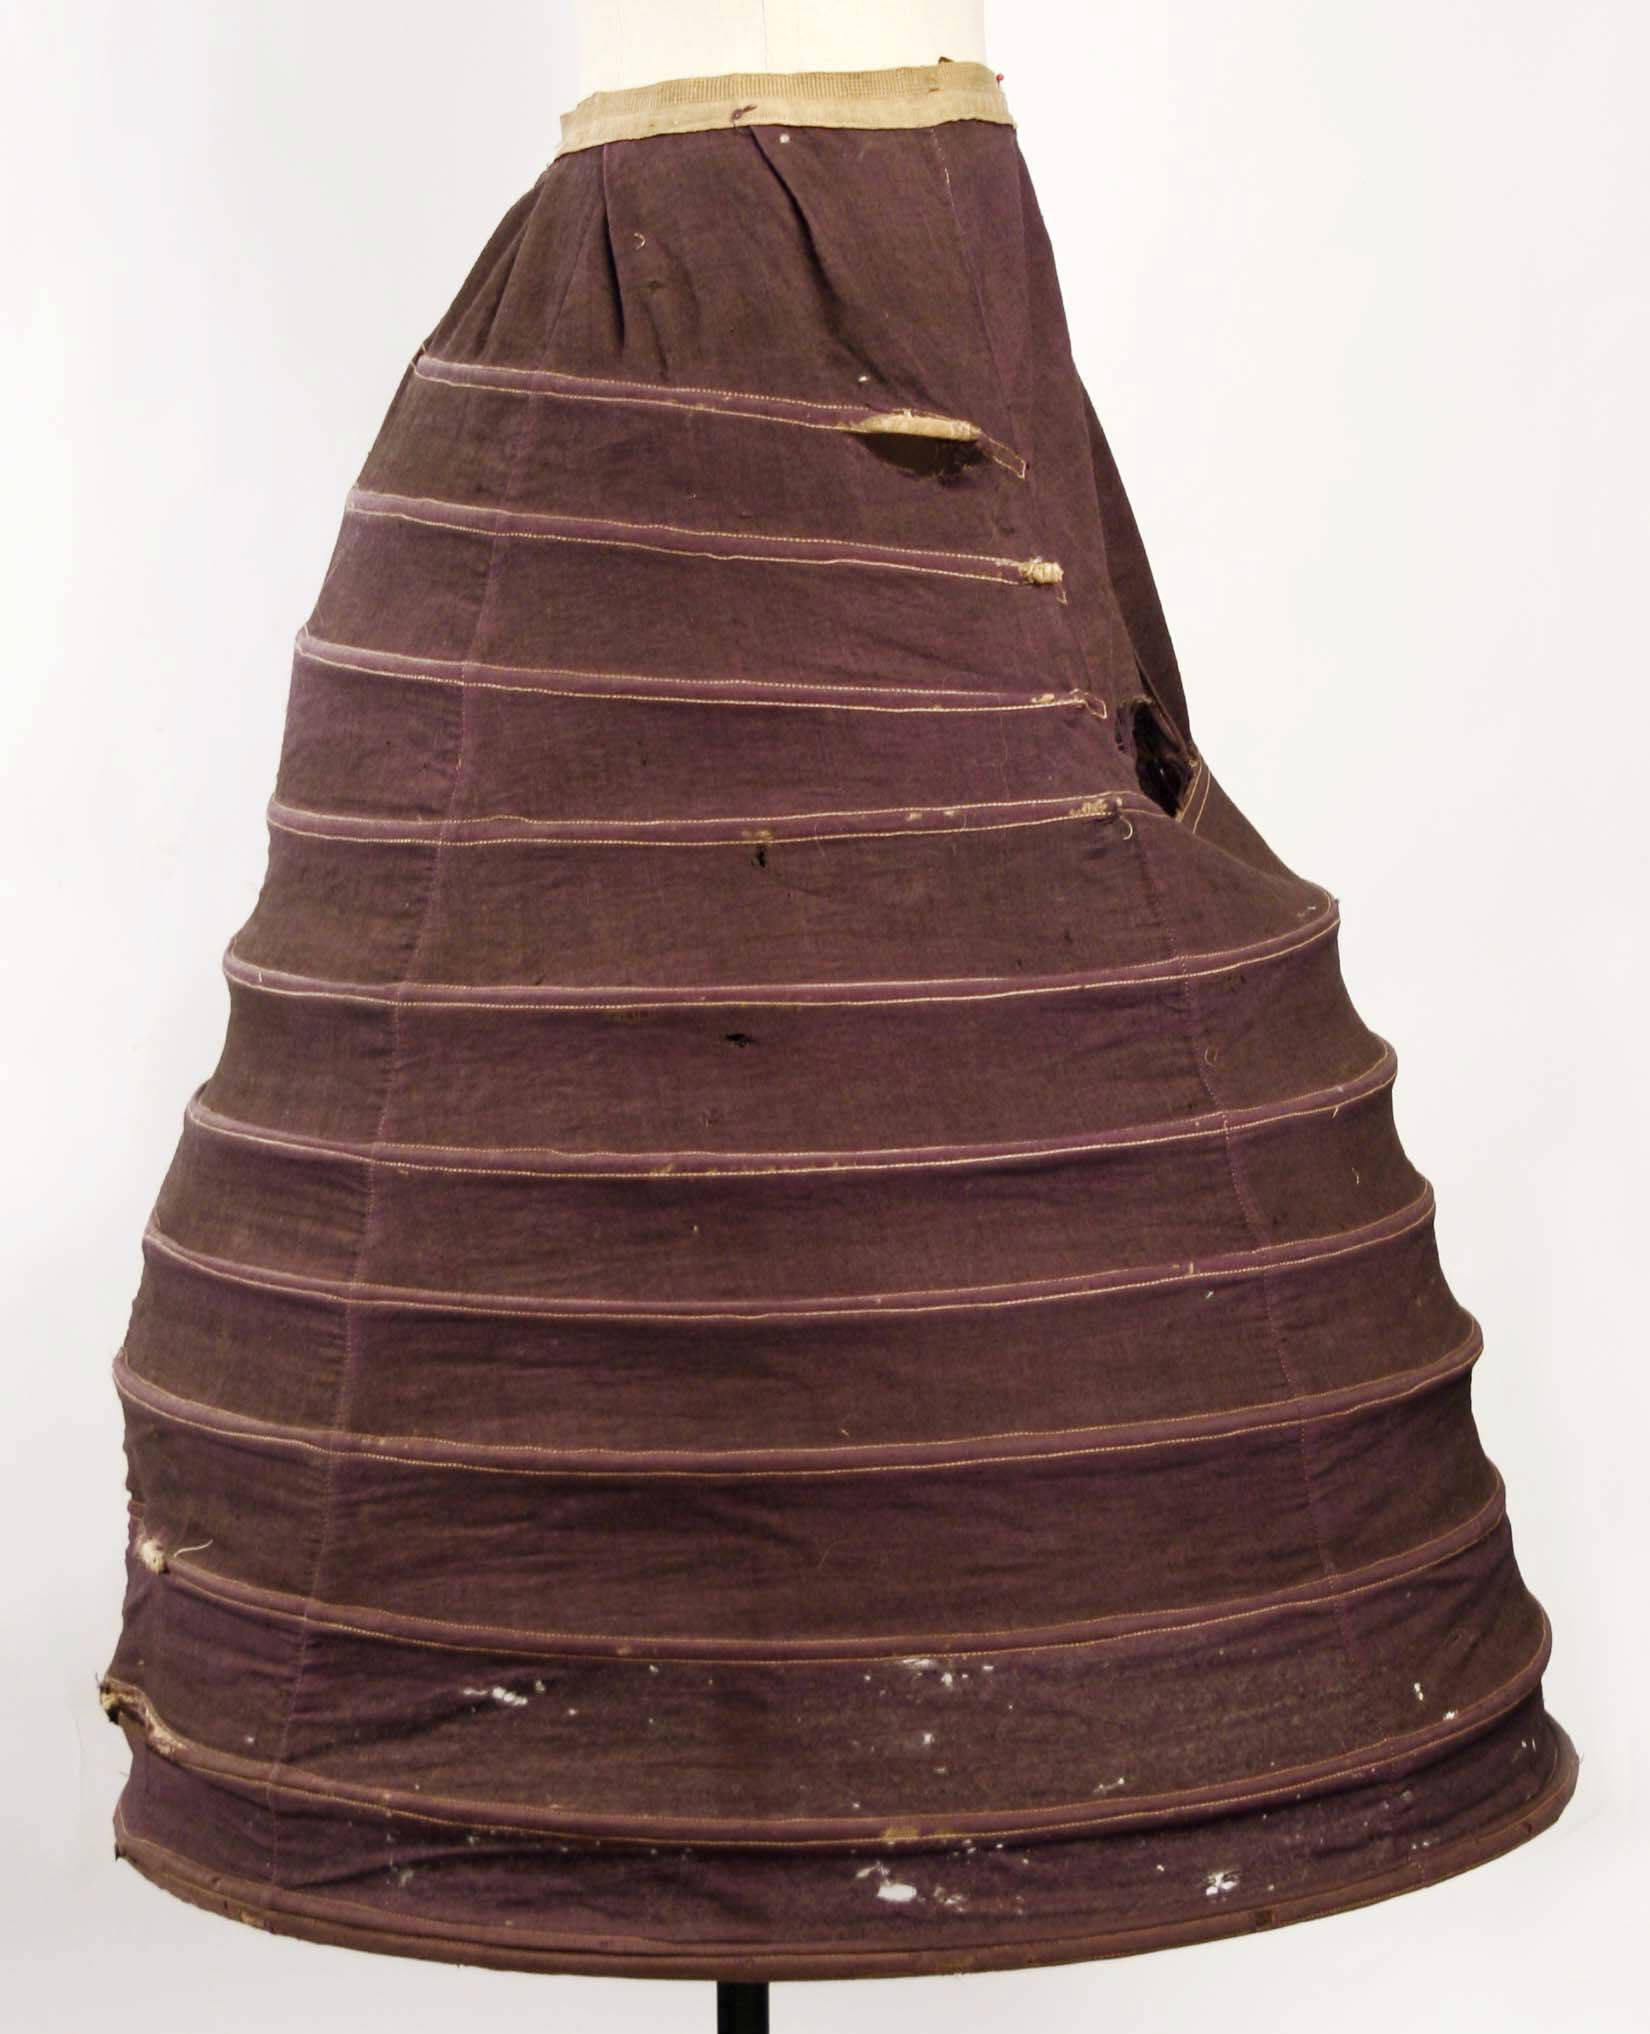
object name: crinoline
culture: american or european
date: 1834-1866